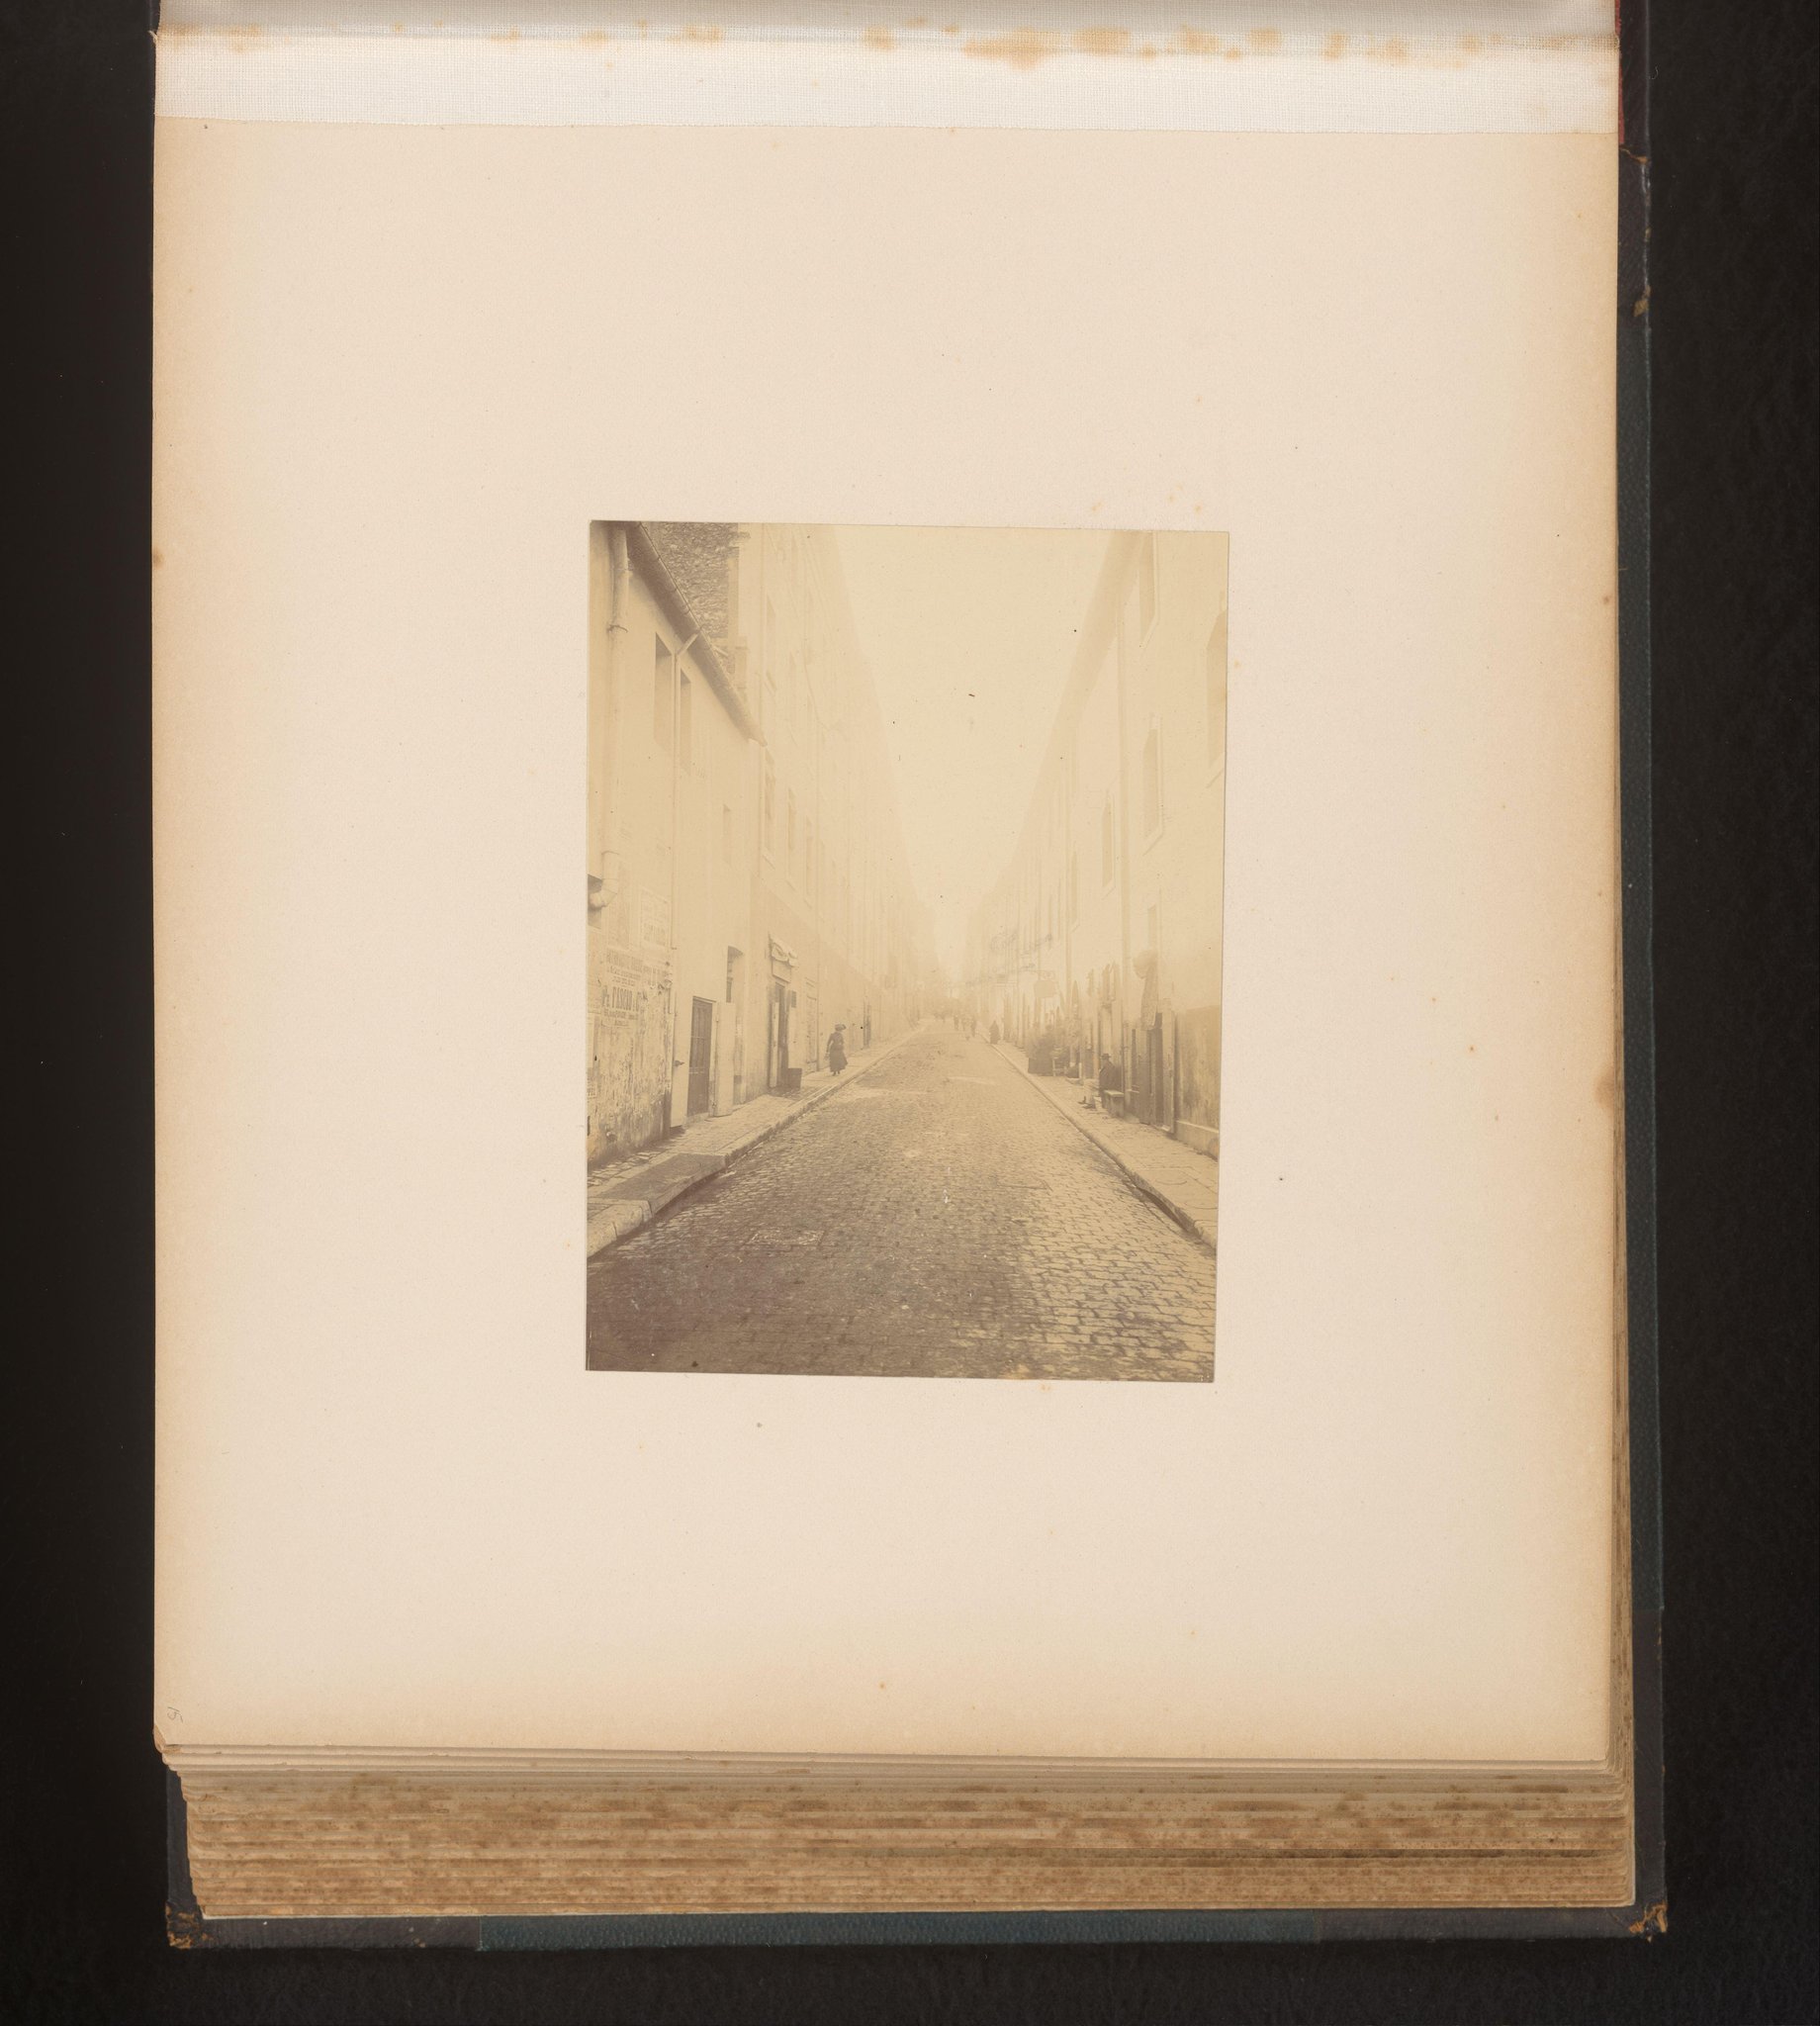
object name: album leaf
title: Straatgezicht te Frankrijk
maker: Anonymous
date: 1880-1920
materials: cardboard, photographic support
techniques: gelatin silver print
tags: historical persons, civic architecture; edifices; dwellings, street, france